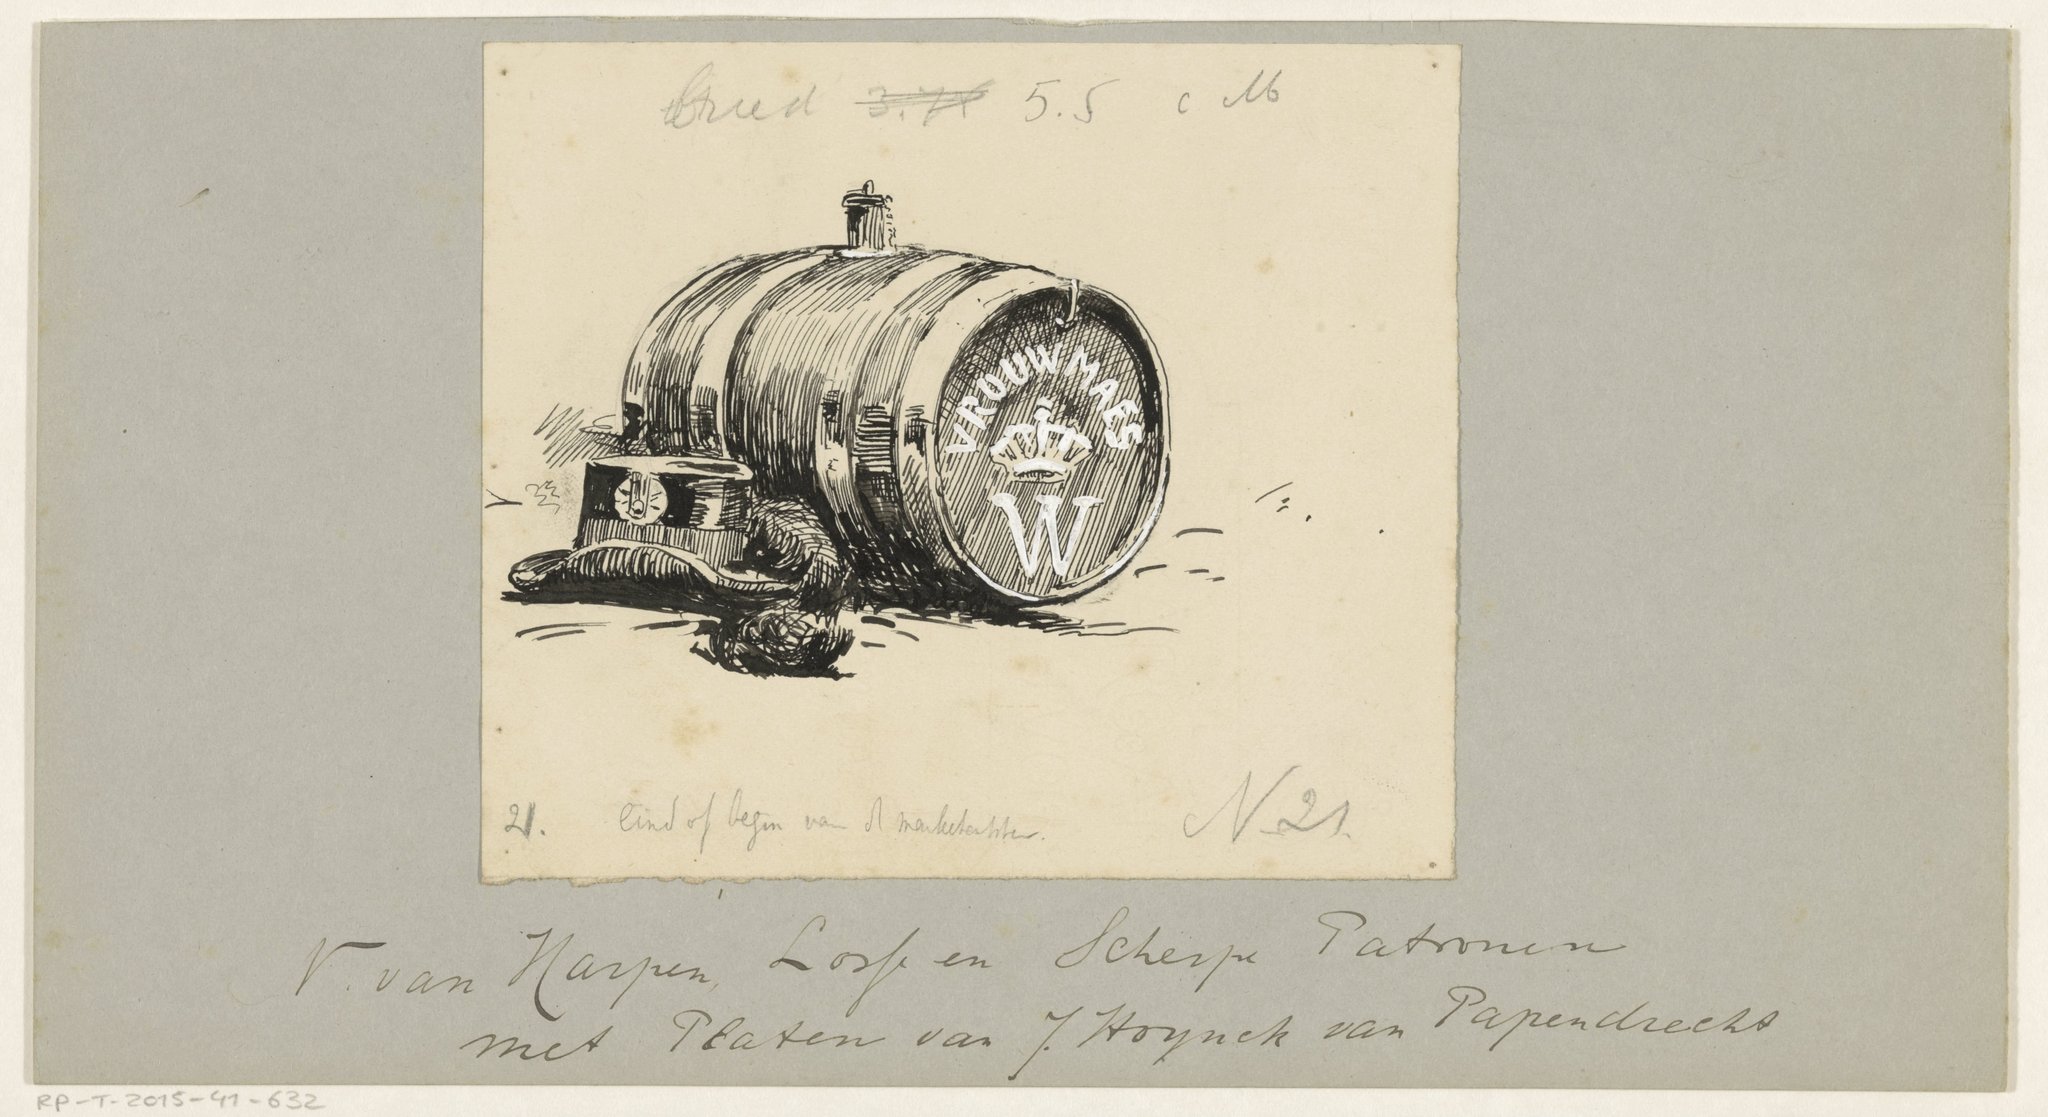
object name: boekillustratie ontwerp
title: Hoed en vat van een marketentster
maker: jan hoynck van papendrecht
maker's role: draughtsman, painter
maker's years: 1858-1933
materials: paint, ink, paper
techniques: brush, pen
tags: wooden container: barrel, cask, bucket, head-gear: hat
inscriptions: annotation: ‘21. eind of begin van [...] marketentster. N 21’, annotation: ‘N. van Harpen, Losse en Scherpe Patronen/ met Platen van J. Hoynck van Papendrecht’, collector's mark: Lugt 2228, :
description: Ontwerp voor: Harpen, N. van. Losse en scherpe patronen. Amsterdam: Veen, 1889.